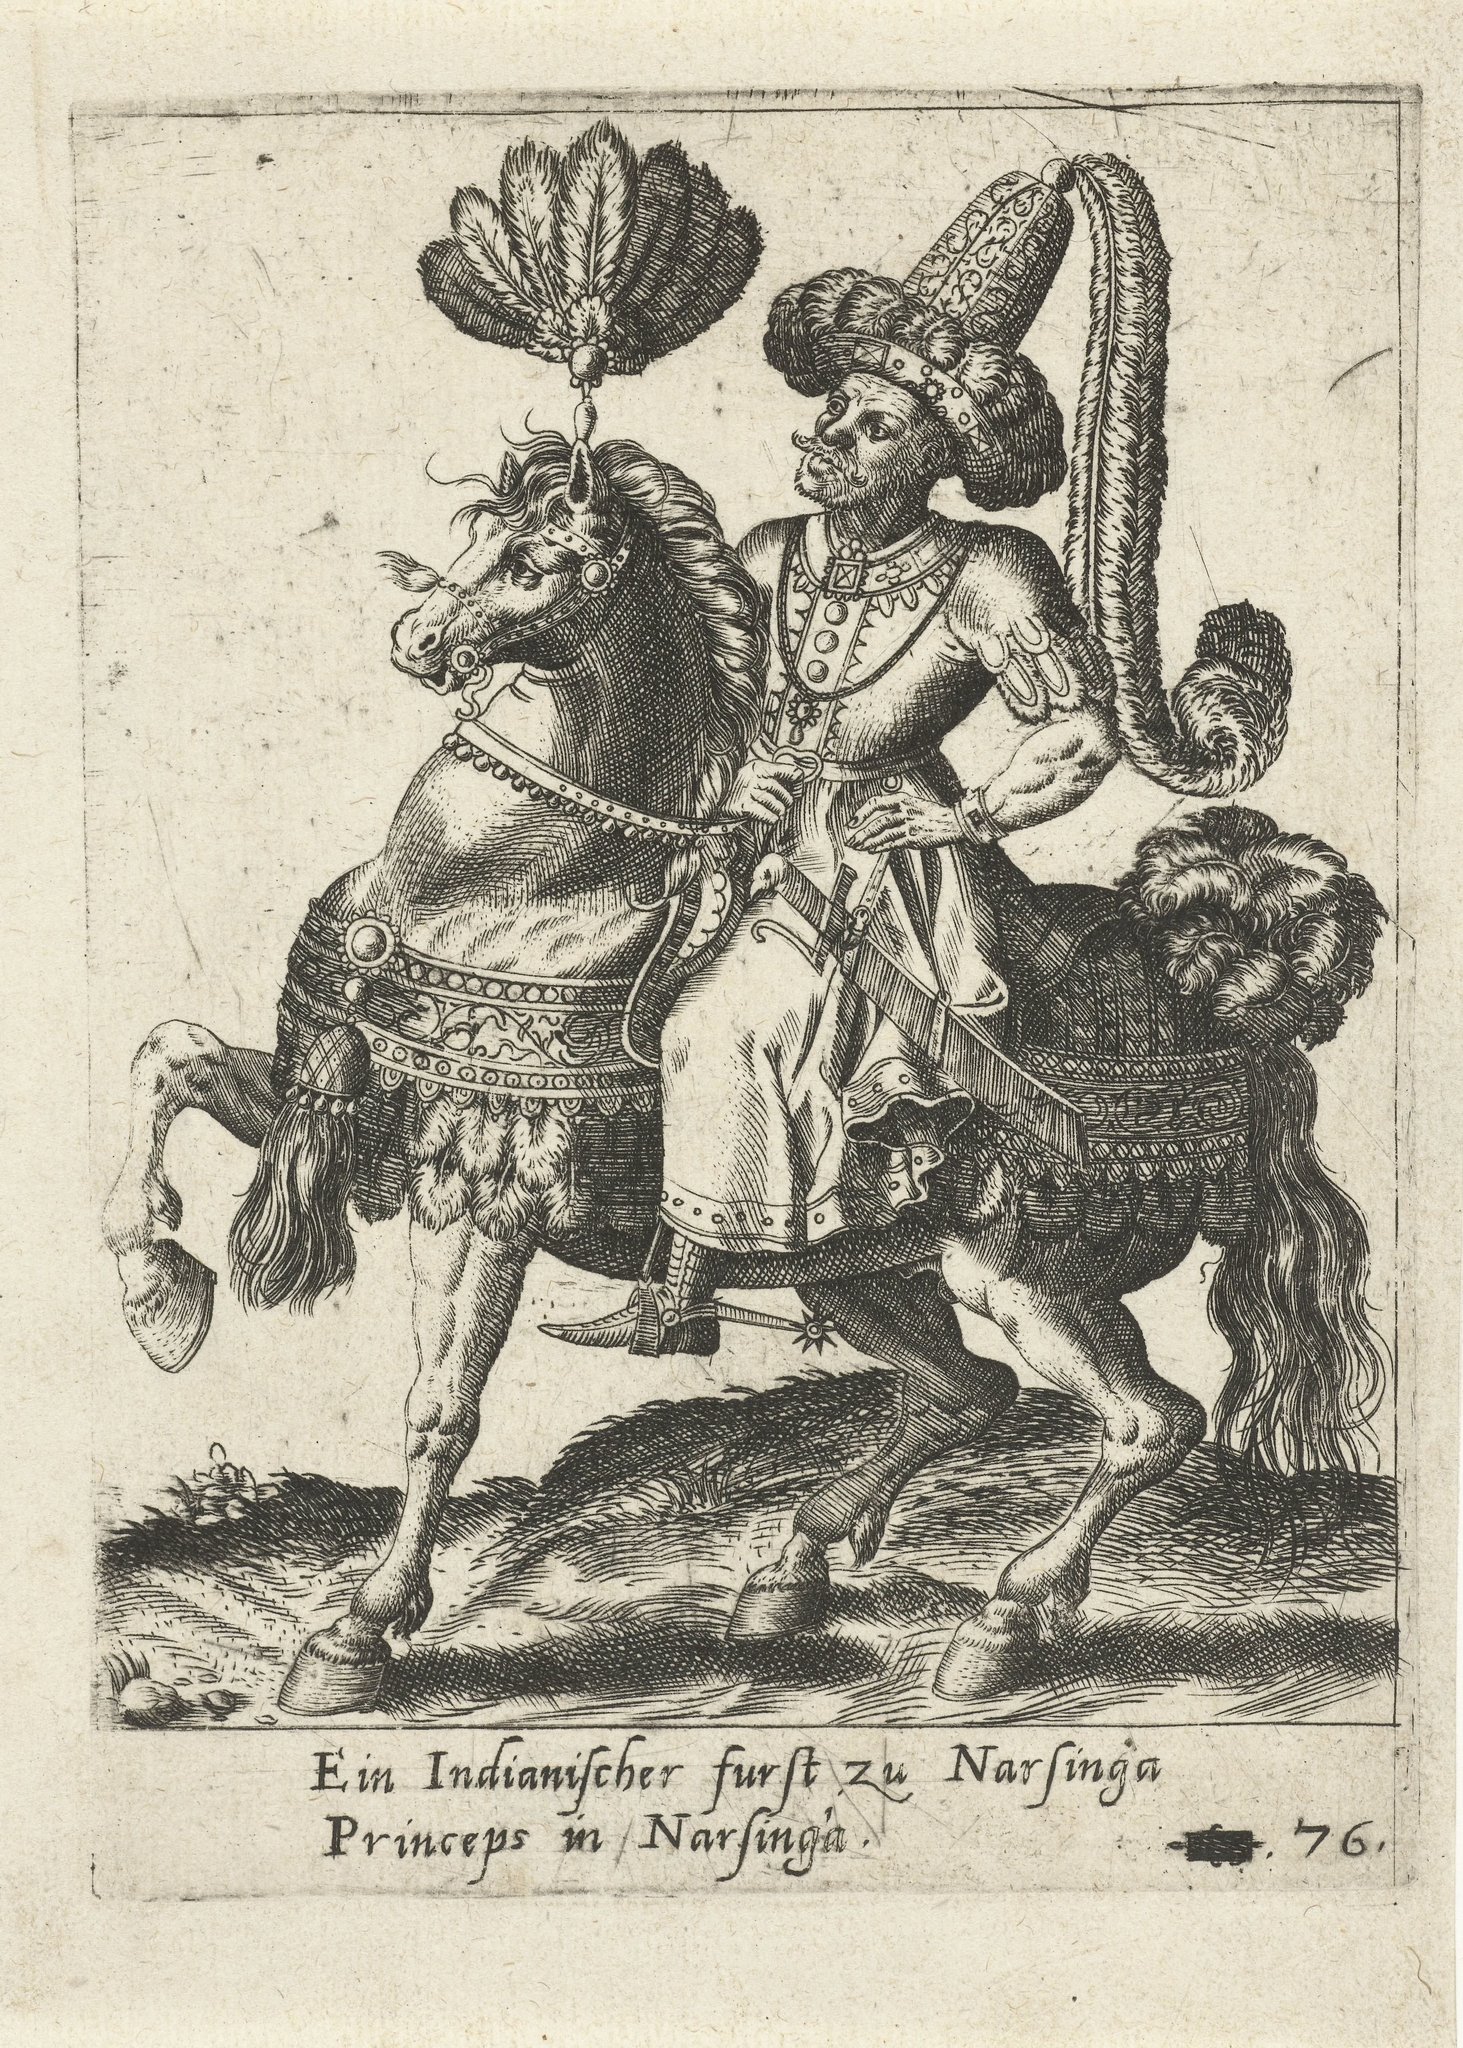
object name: costume print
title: Indiase vorst te paard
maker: abraham de bruyn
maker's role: print maker, publisher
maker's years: 1540-1587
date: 1577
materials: paper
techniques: engraving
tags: warfare; military affairs (+ cavalry, horsemen), folk costume, regional costume, king, asiatic races and peoples: indians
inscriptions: collector's mark: Lugt 2228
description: Prent oorspronkelijk verschenen in 'Equitum descripcio, quomodo equestres copie, nostra hac aetate, in sua armatura, per cunttas, videlicet Europae, Asiae et Affrice, nationes in re militare sese habent nunc primum', Keulen 1577.